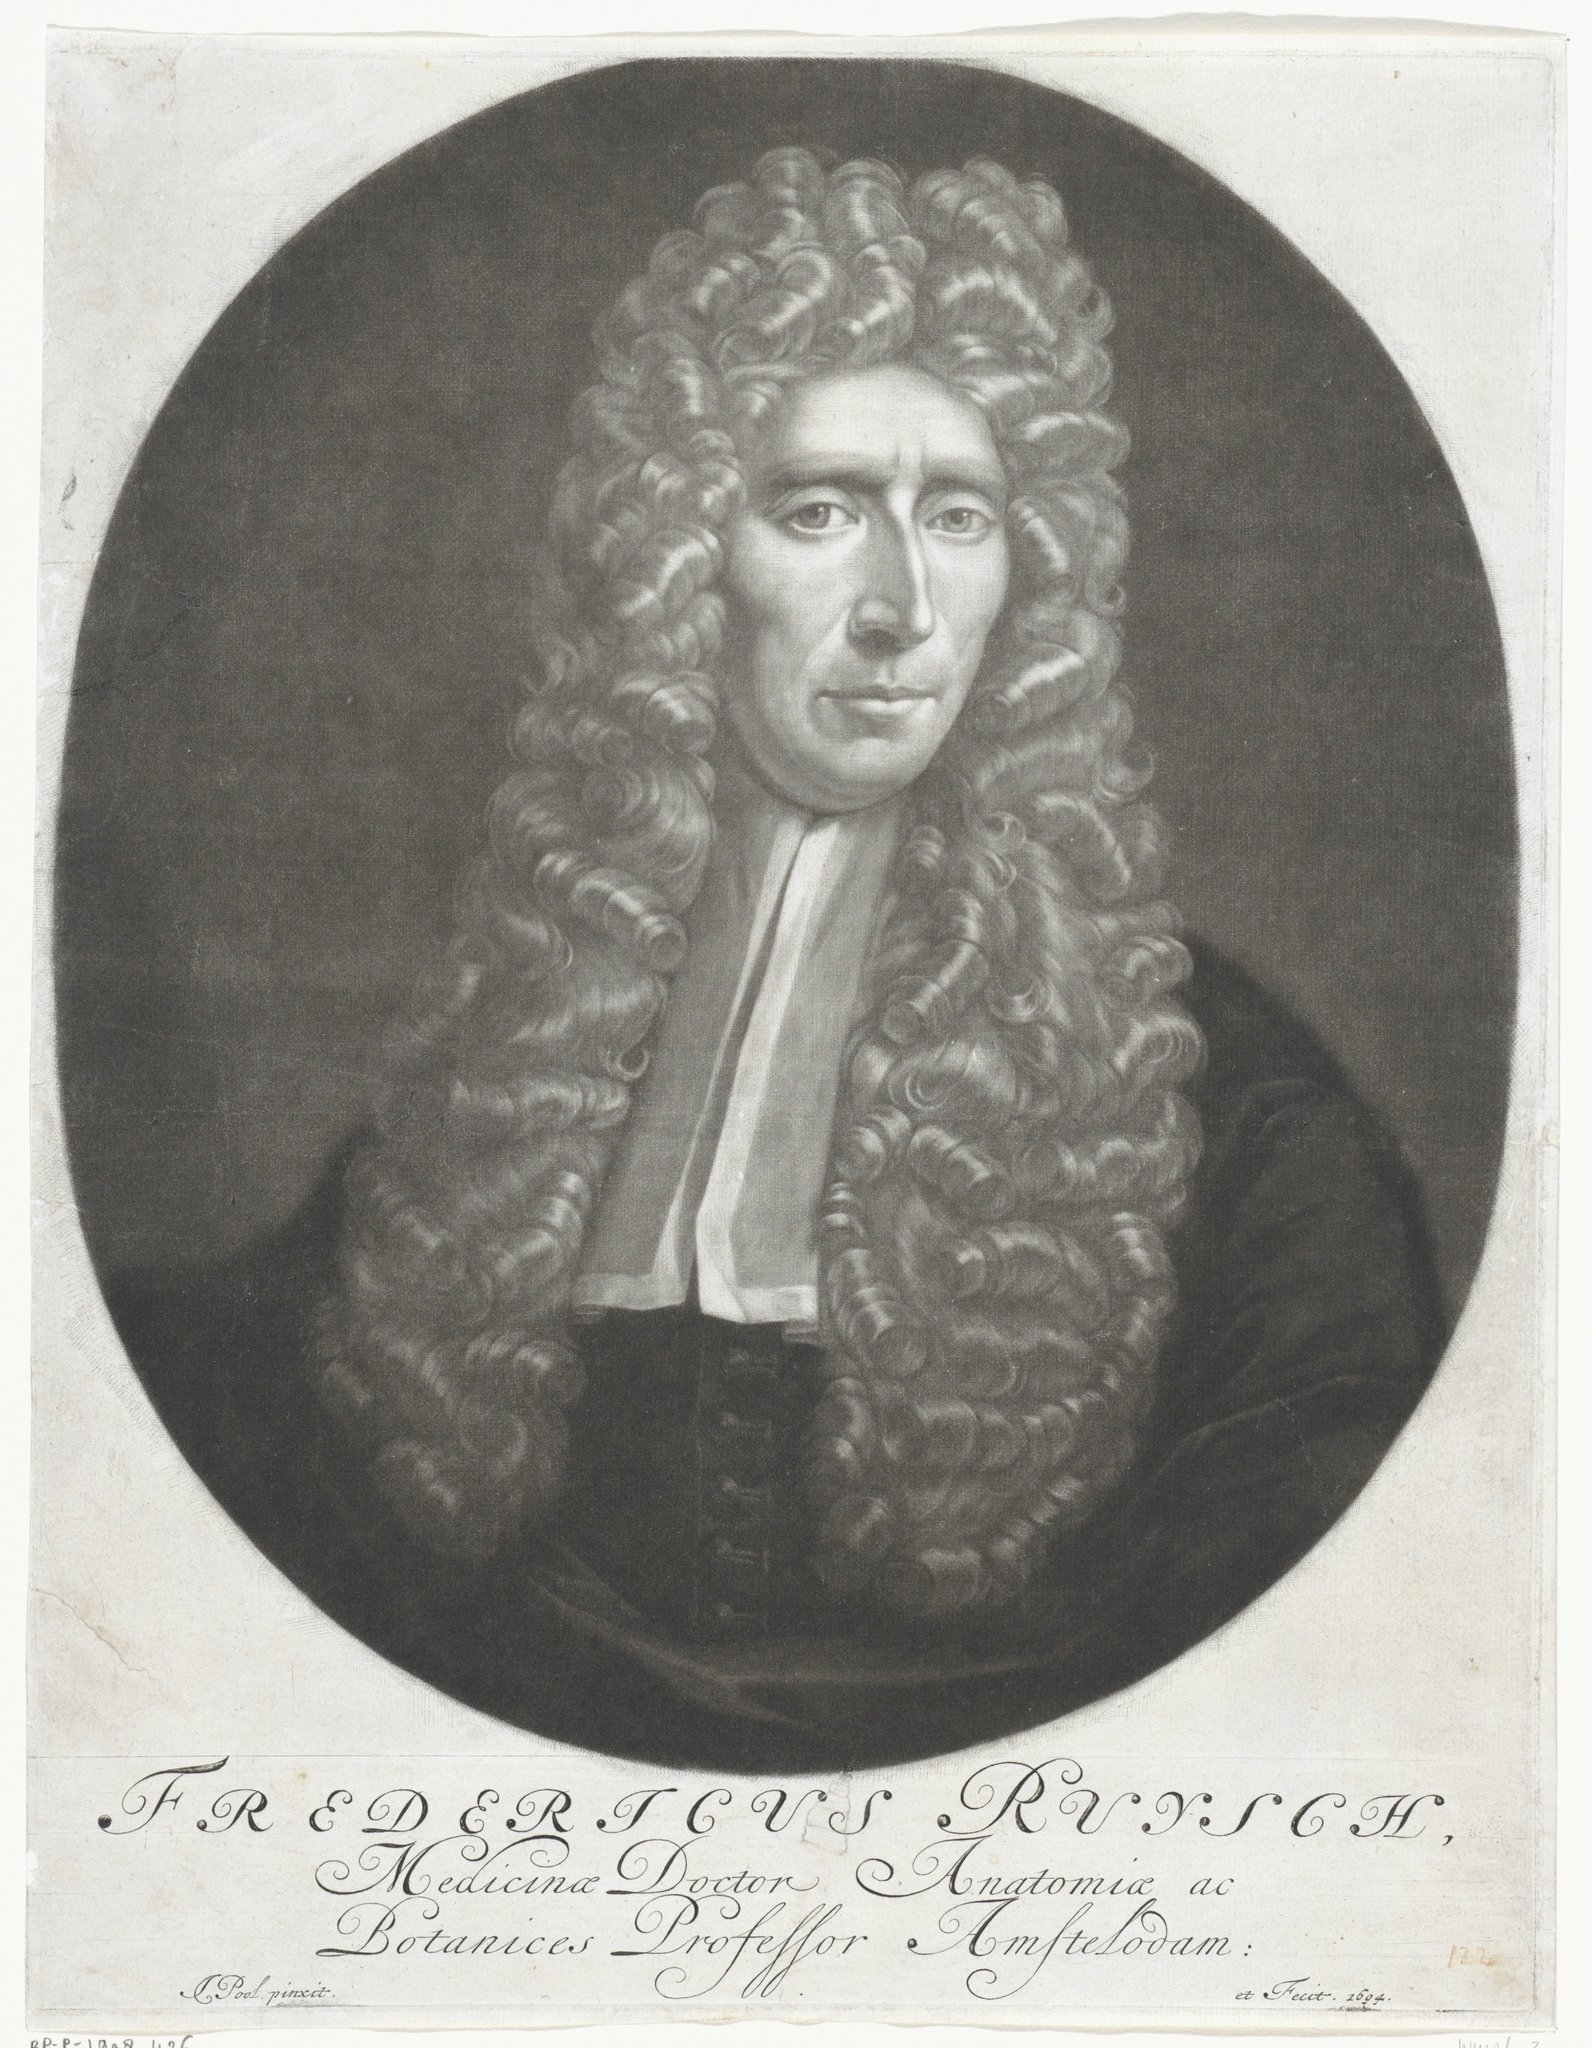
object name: print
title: Portret van de arts en botanicus Frederick Ruysch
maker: juriaen pool (ii)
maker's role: print maker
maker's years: 1665-1745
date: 1694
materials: paper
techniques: engraving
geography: amsterdam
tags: the hague, frederik ruysch, wig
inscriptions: collector's mark: Lugt 2228